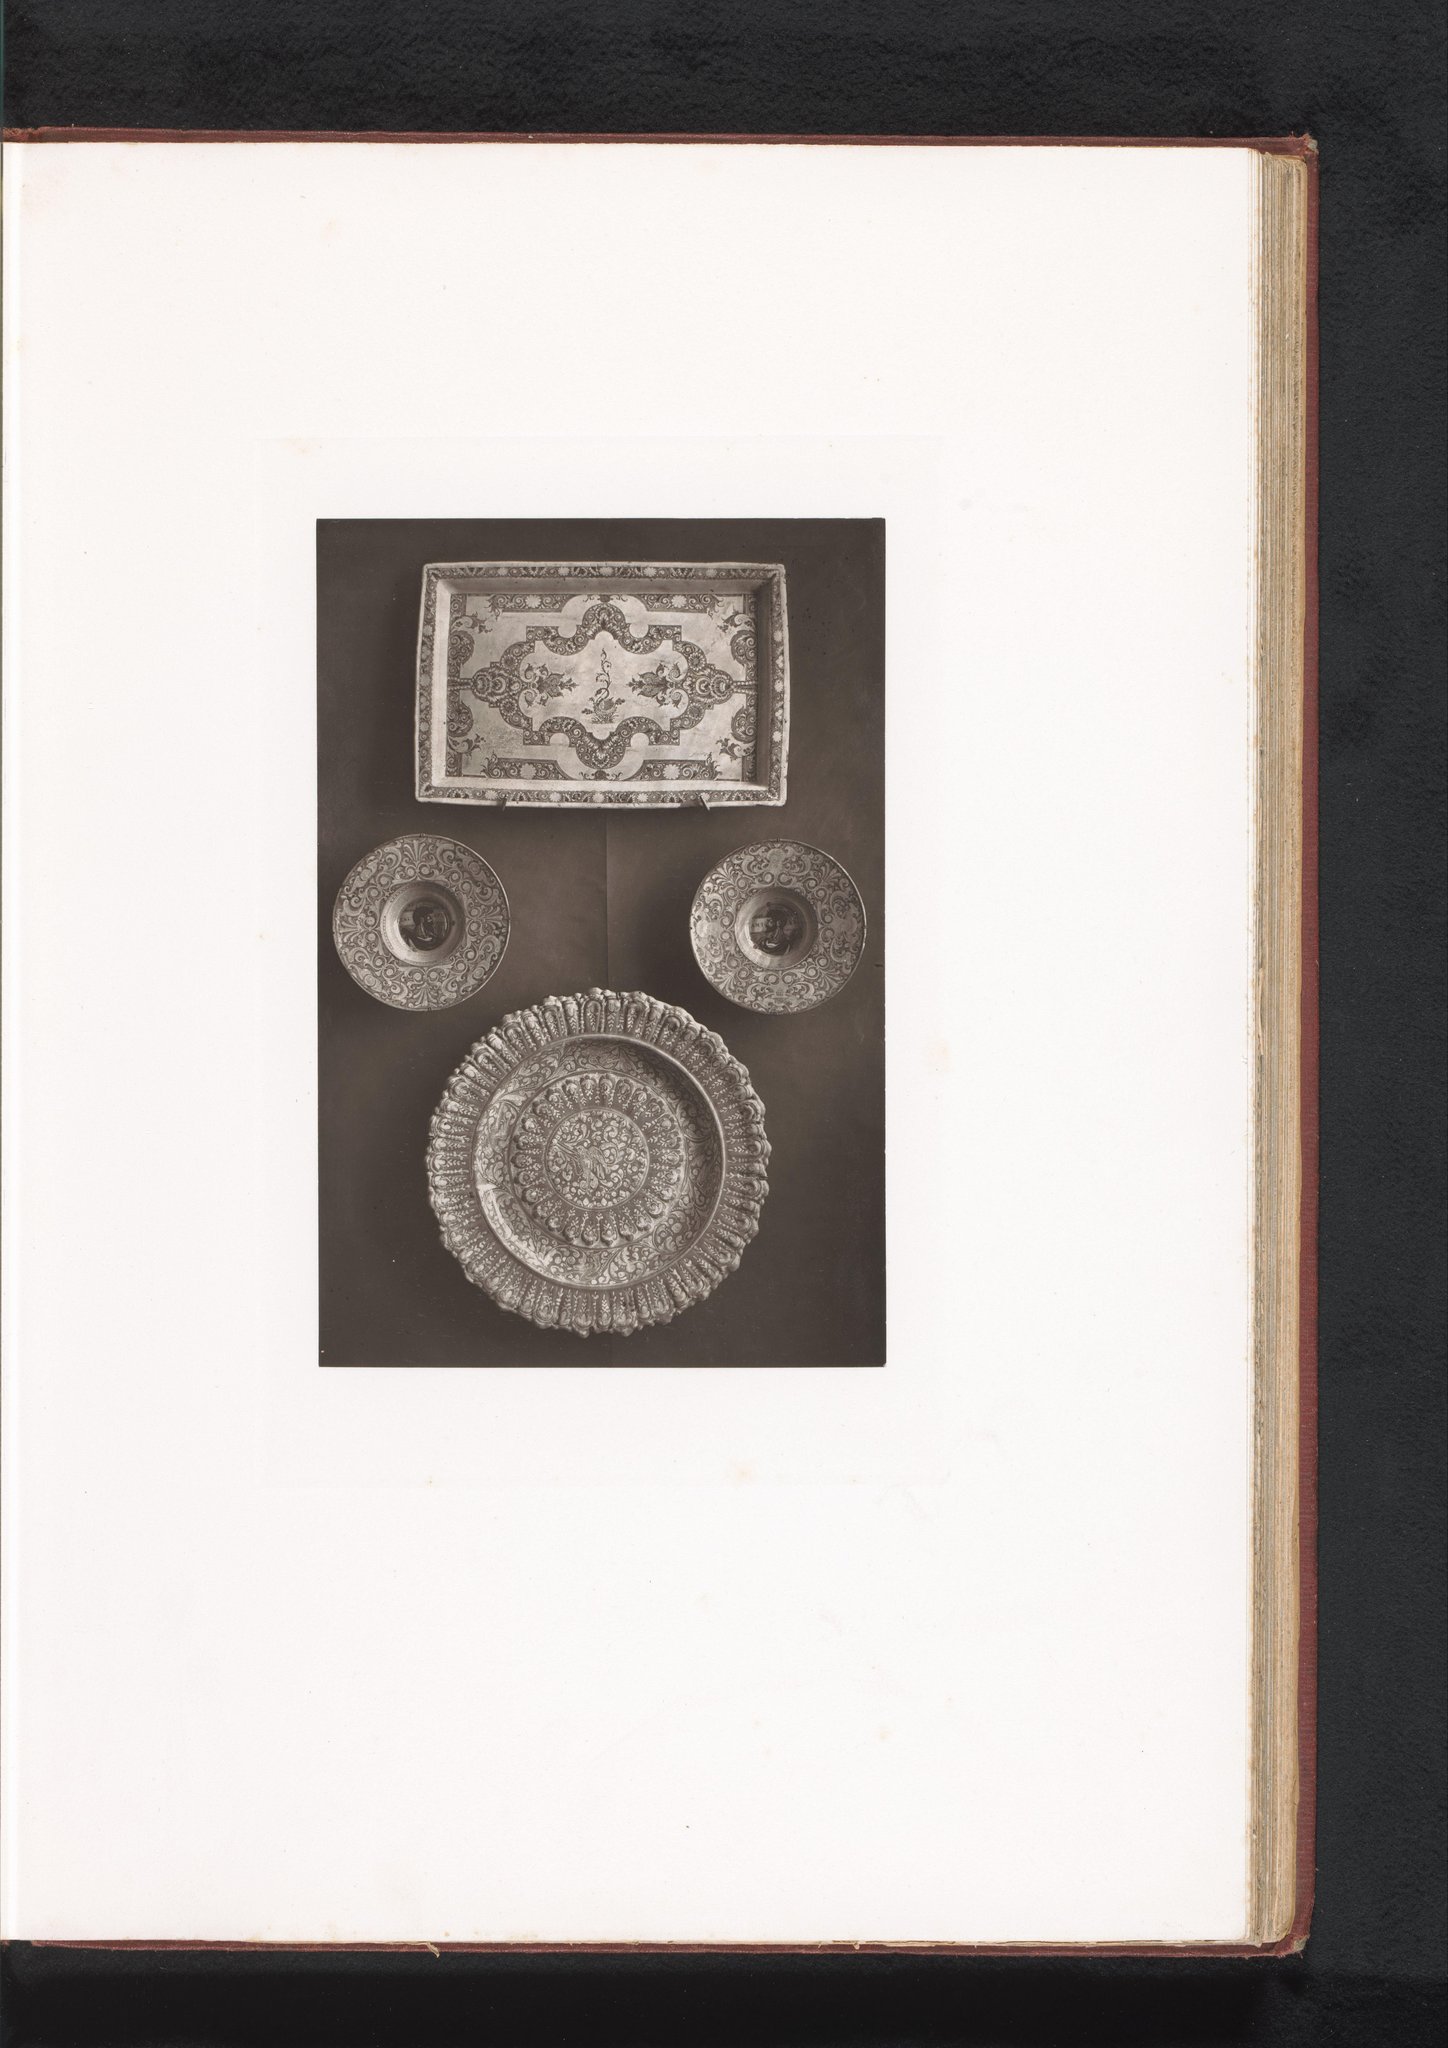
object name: page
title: Vier schalen van aardewerk, opgesteld tijdens de Exposition Rétrospective van 1873 in Tours, Frankrijk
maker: gabriel blaise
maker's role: printer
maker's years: 1827-1897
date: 1873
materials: paper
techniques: woodburytype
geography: tours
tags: dish, plate, saucer, temporary exhibition, 'salon'